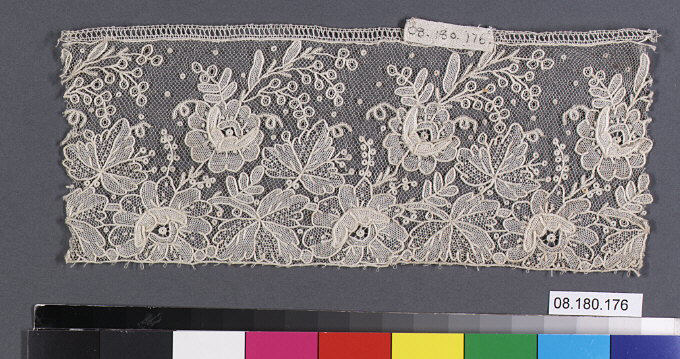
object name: fragment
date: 1801-1900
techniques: lace